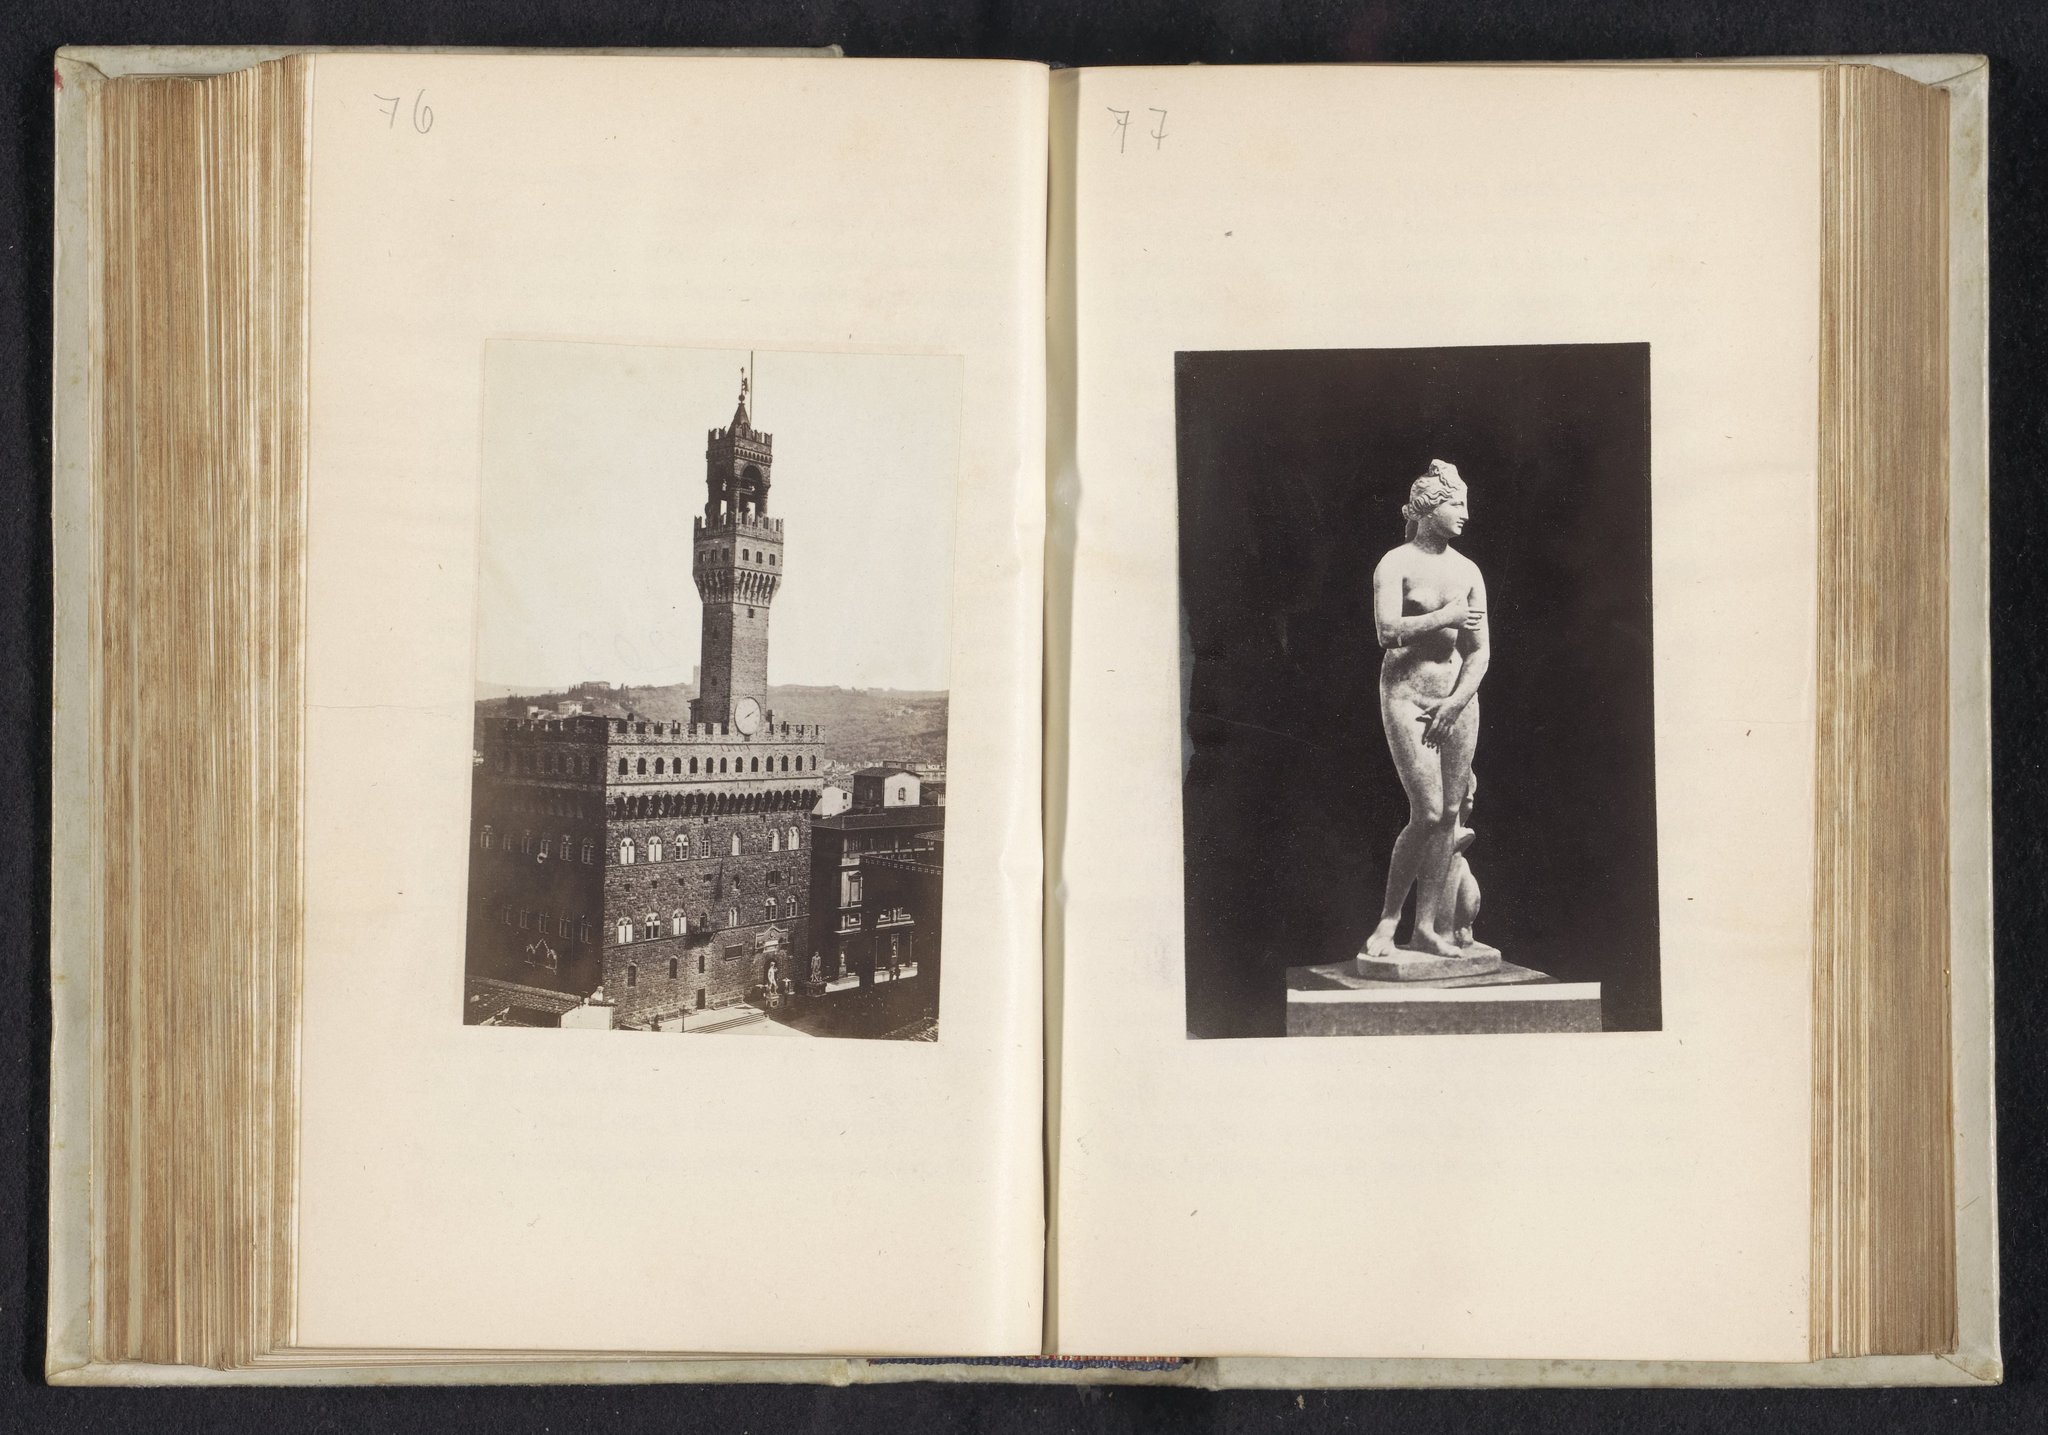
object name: page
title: Sculptuur van de Capitolijnse Venus in de Capitolijnse Musea te Rome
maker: Anonymous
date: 1850-1860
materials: photographic support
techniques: albumen print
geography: capitolijnse musea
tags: bath of venus, sculpture